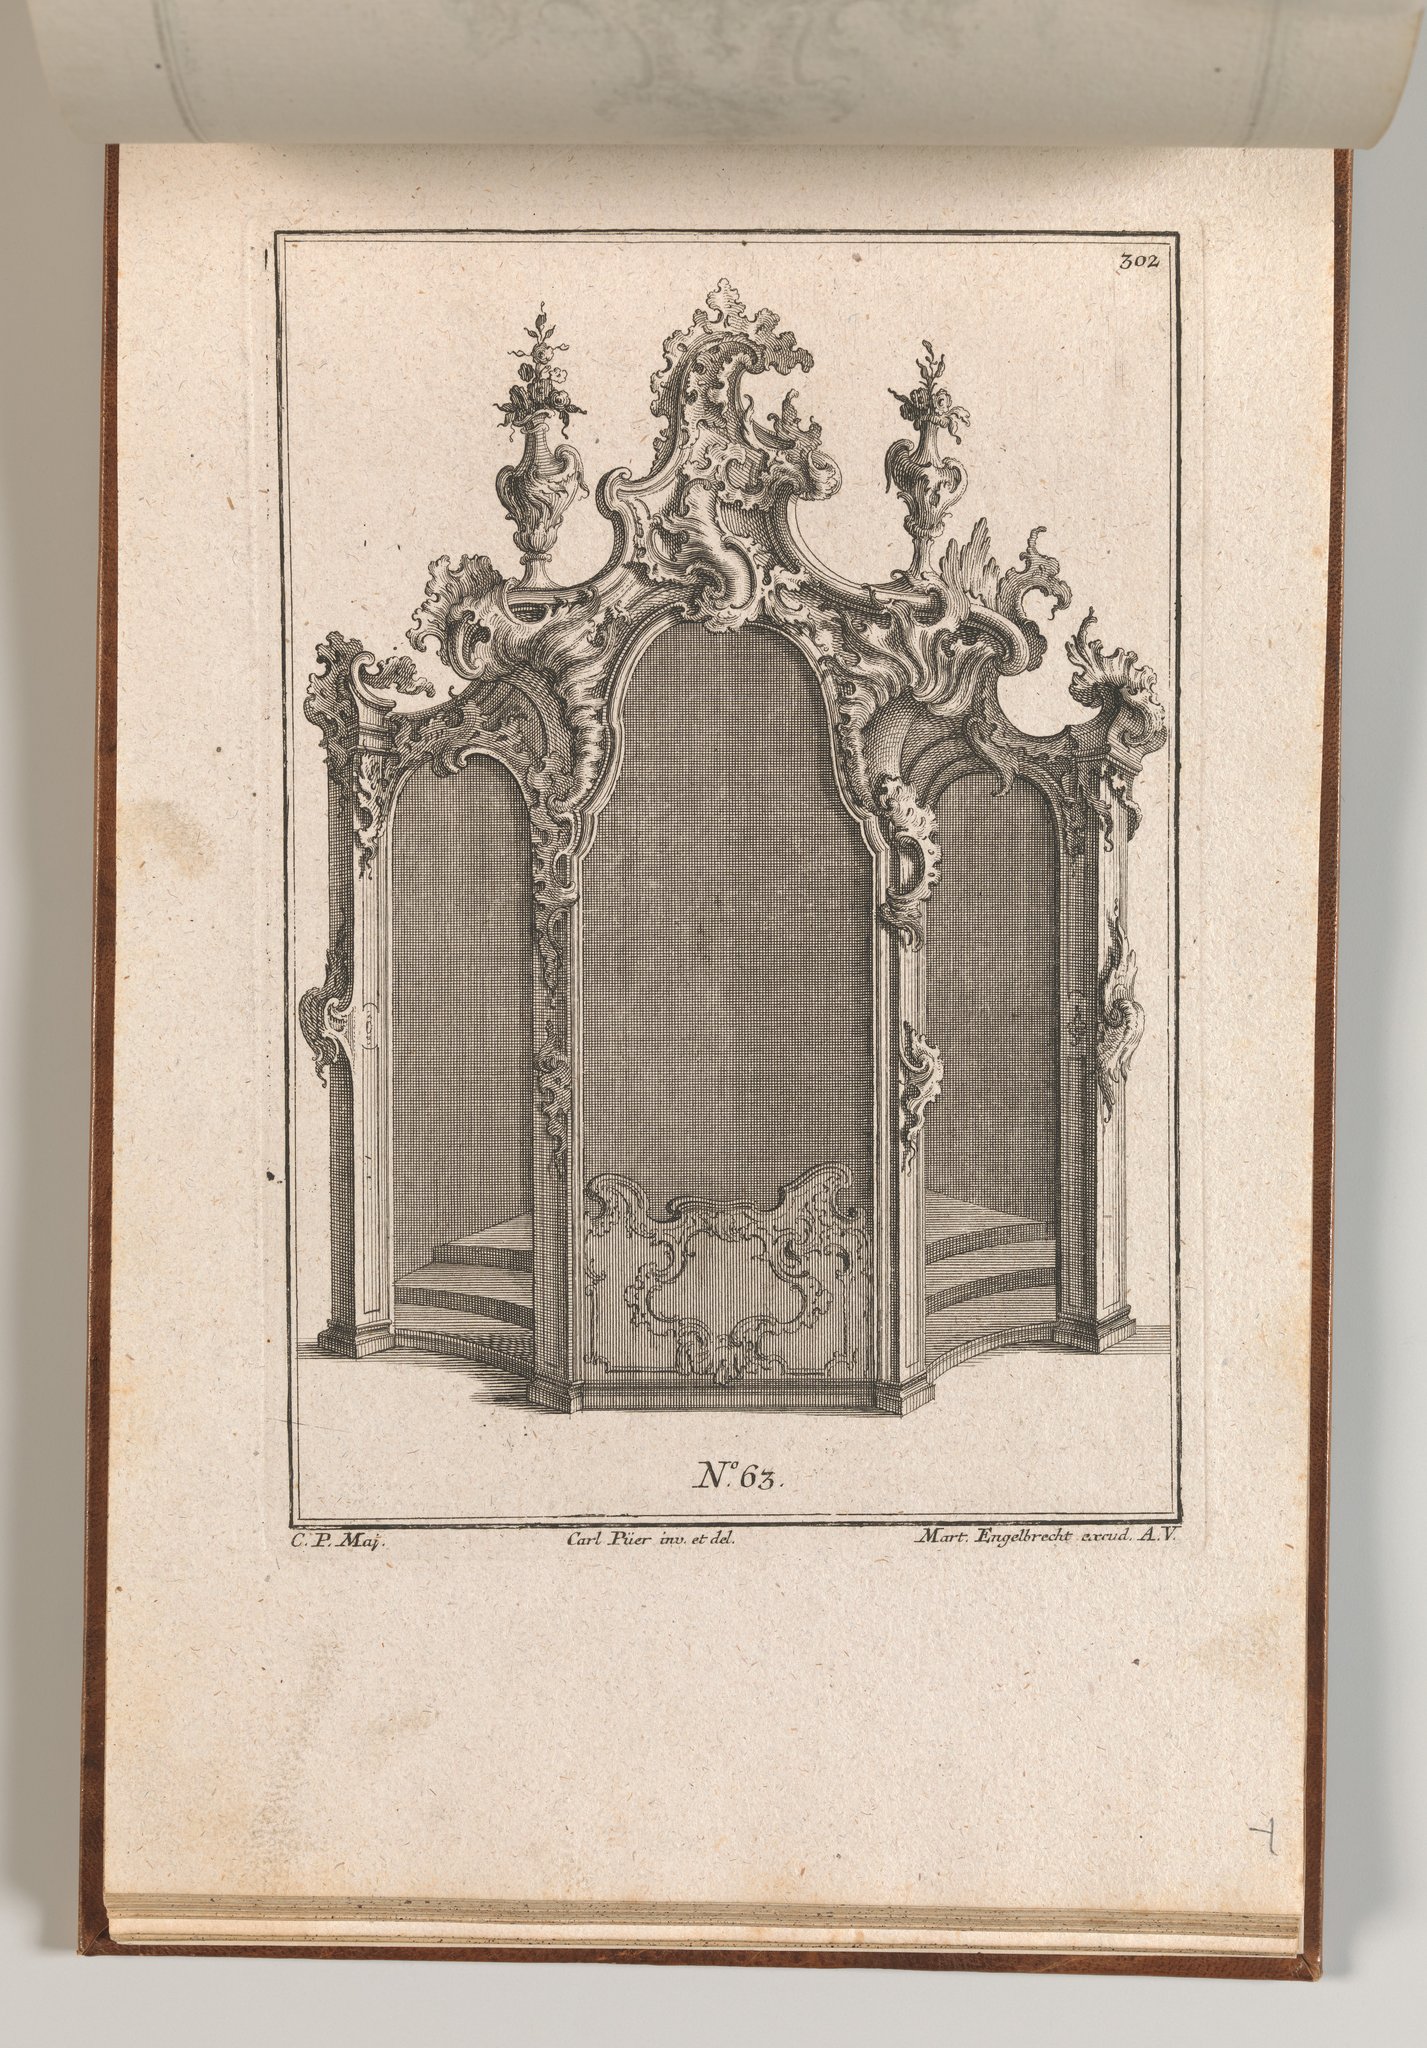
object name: album print ornament architecture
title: Design for a Confessional, Plate 1 from an Untitled Series of Designs for Confessionals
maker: carl pier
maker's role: artist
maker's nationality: german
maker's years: 1700-1790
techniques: etching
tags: architecture